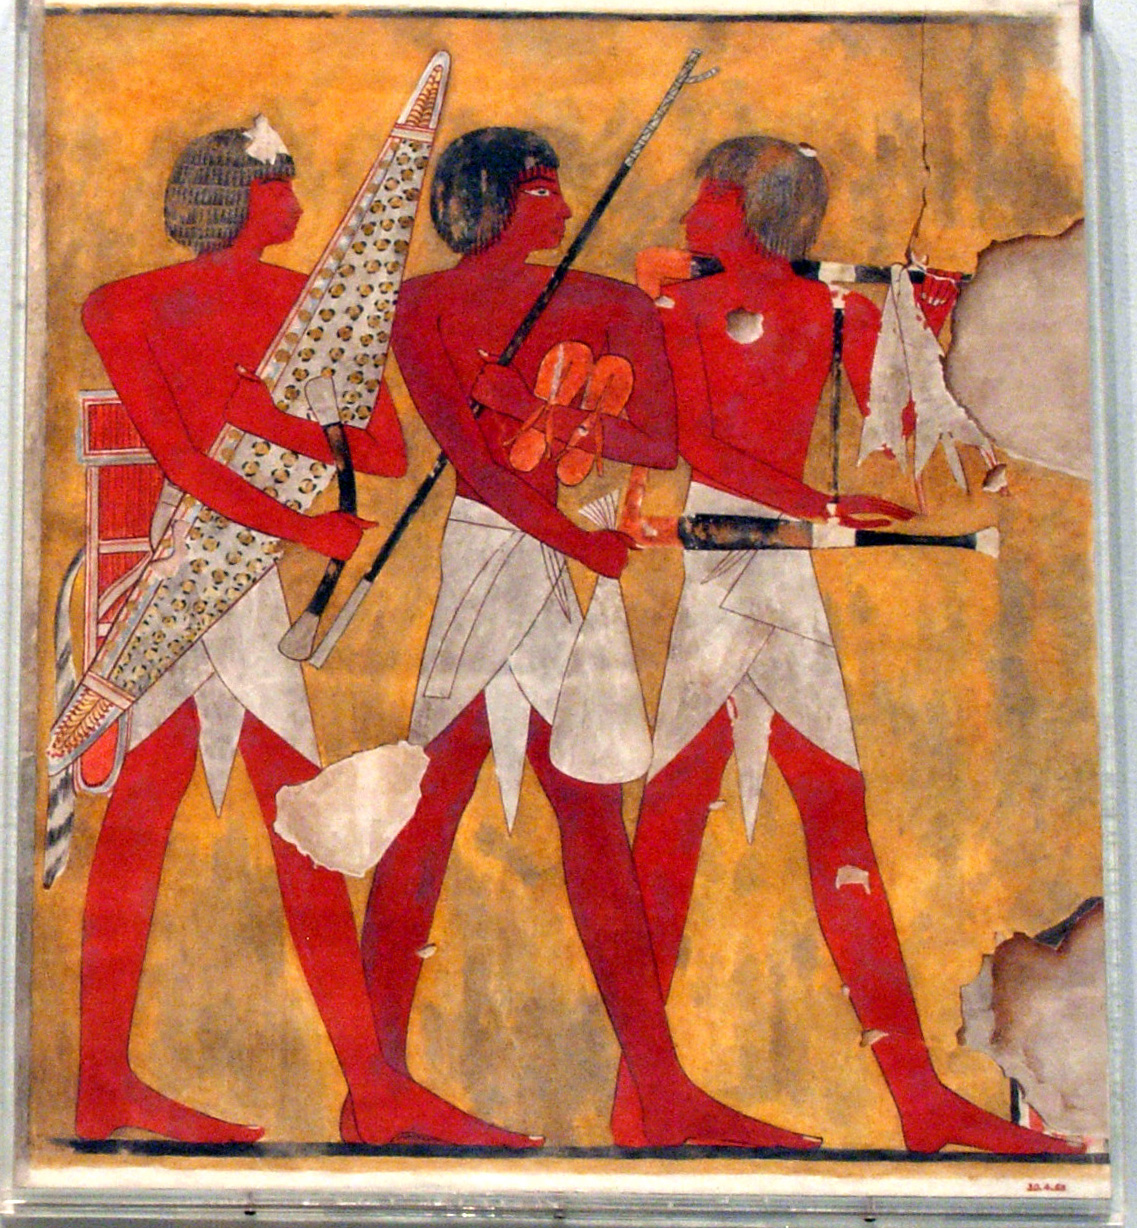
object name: facsimile, qenamun tt 93, hunting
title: Attendants for a Hunting Expedition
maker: hugh r. hopgood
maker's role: artist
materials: paper, paint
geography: egypt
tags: men